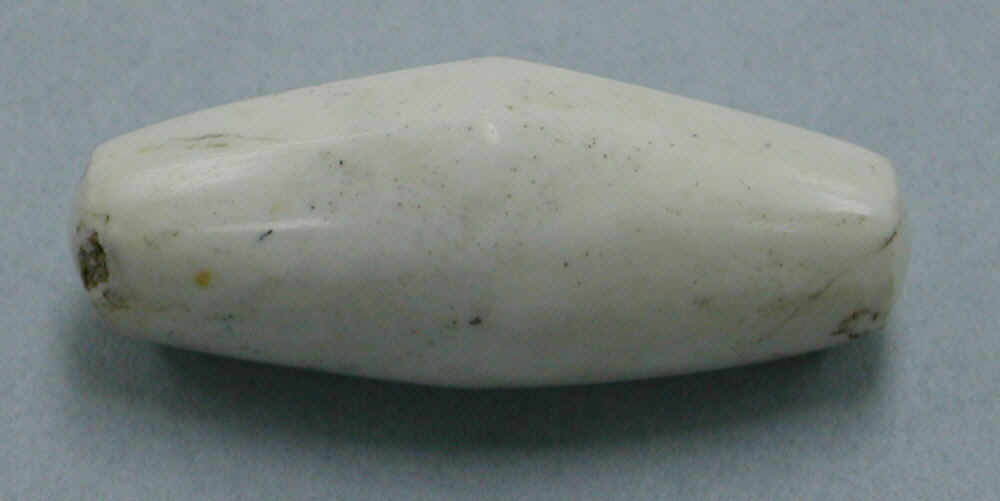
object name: ritual stone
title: Stone Pulidor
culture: mexican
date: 1501-1600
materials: stone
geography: mexico